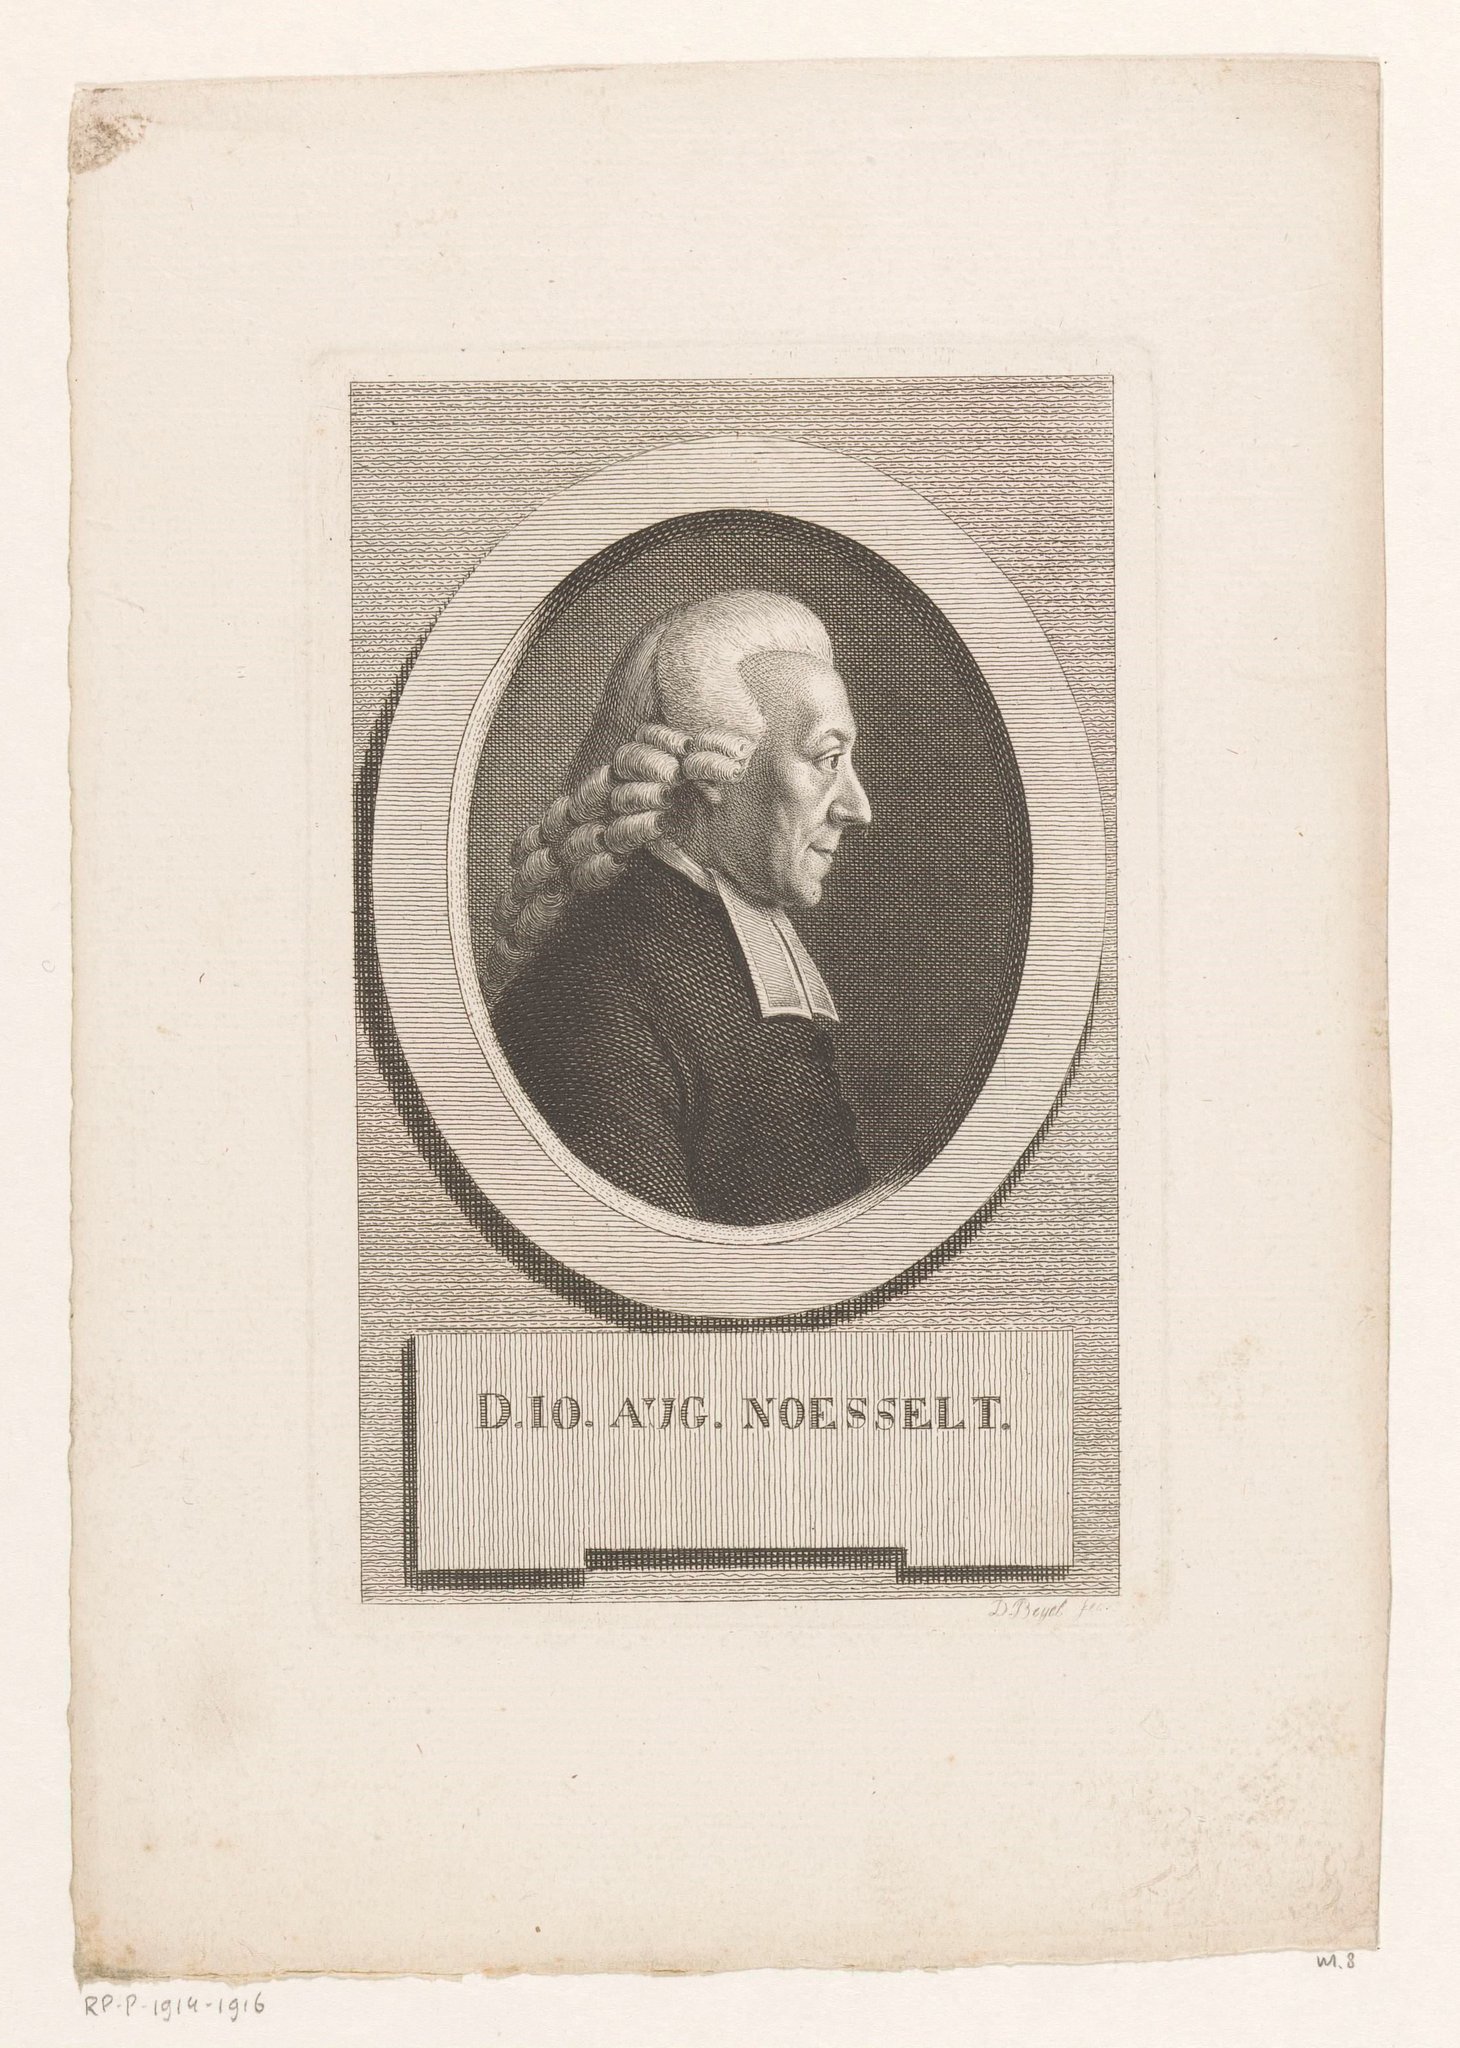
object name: print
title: Portret van Johann August Noesselt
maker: daniel beyel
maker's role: draughtsman, print maker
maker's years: 1760-1823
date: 1793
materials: paper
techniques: engraving, etching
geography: halle an der saale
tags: historical persons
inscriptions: collector's mark: Lugt 2228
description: Prent ook gebruikt in: Allgemeine deutsche Bibliothek. dl. 113, eerste stuk. Kiel: Carl Ernst Bohn, 1793.